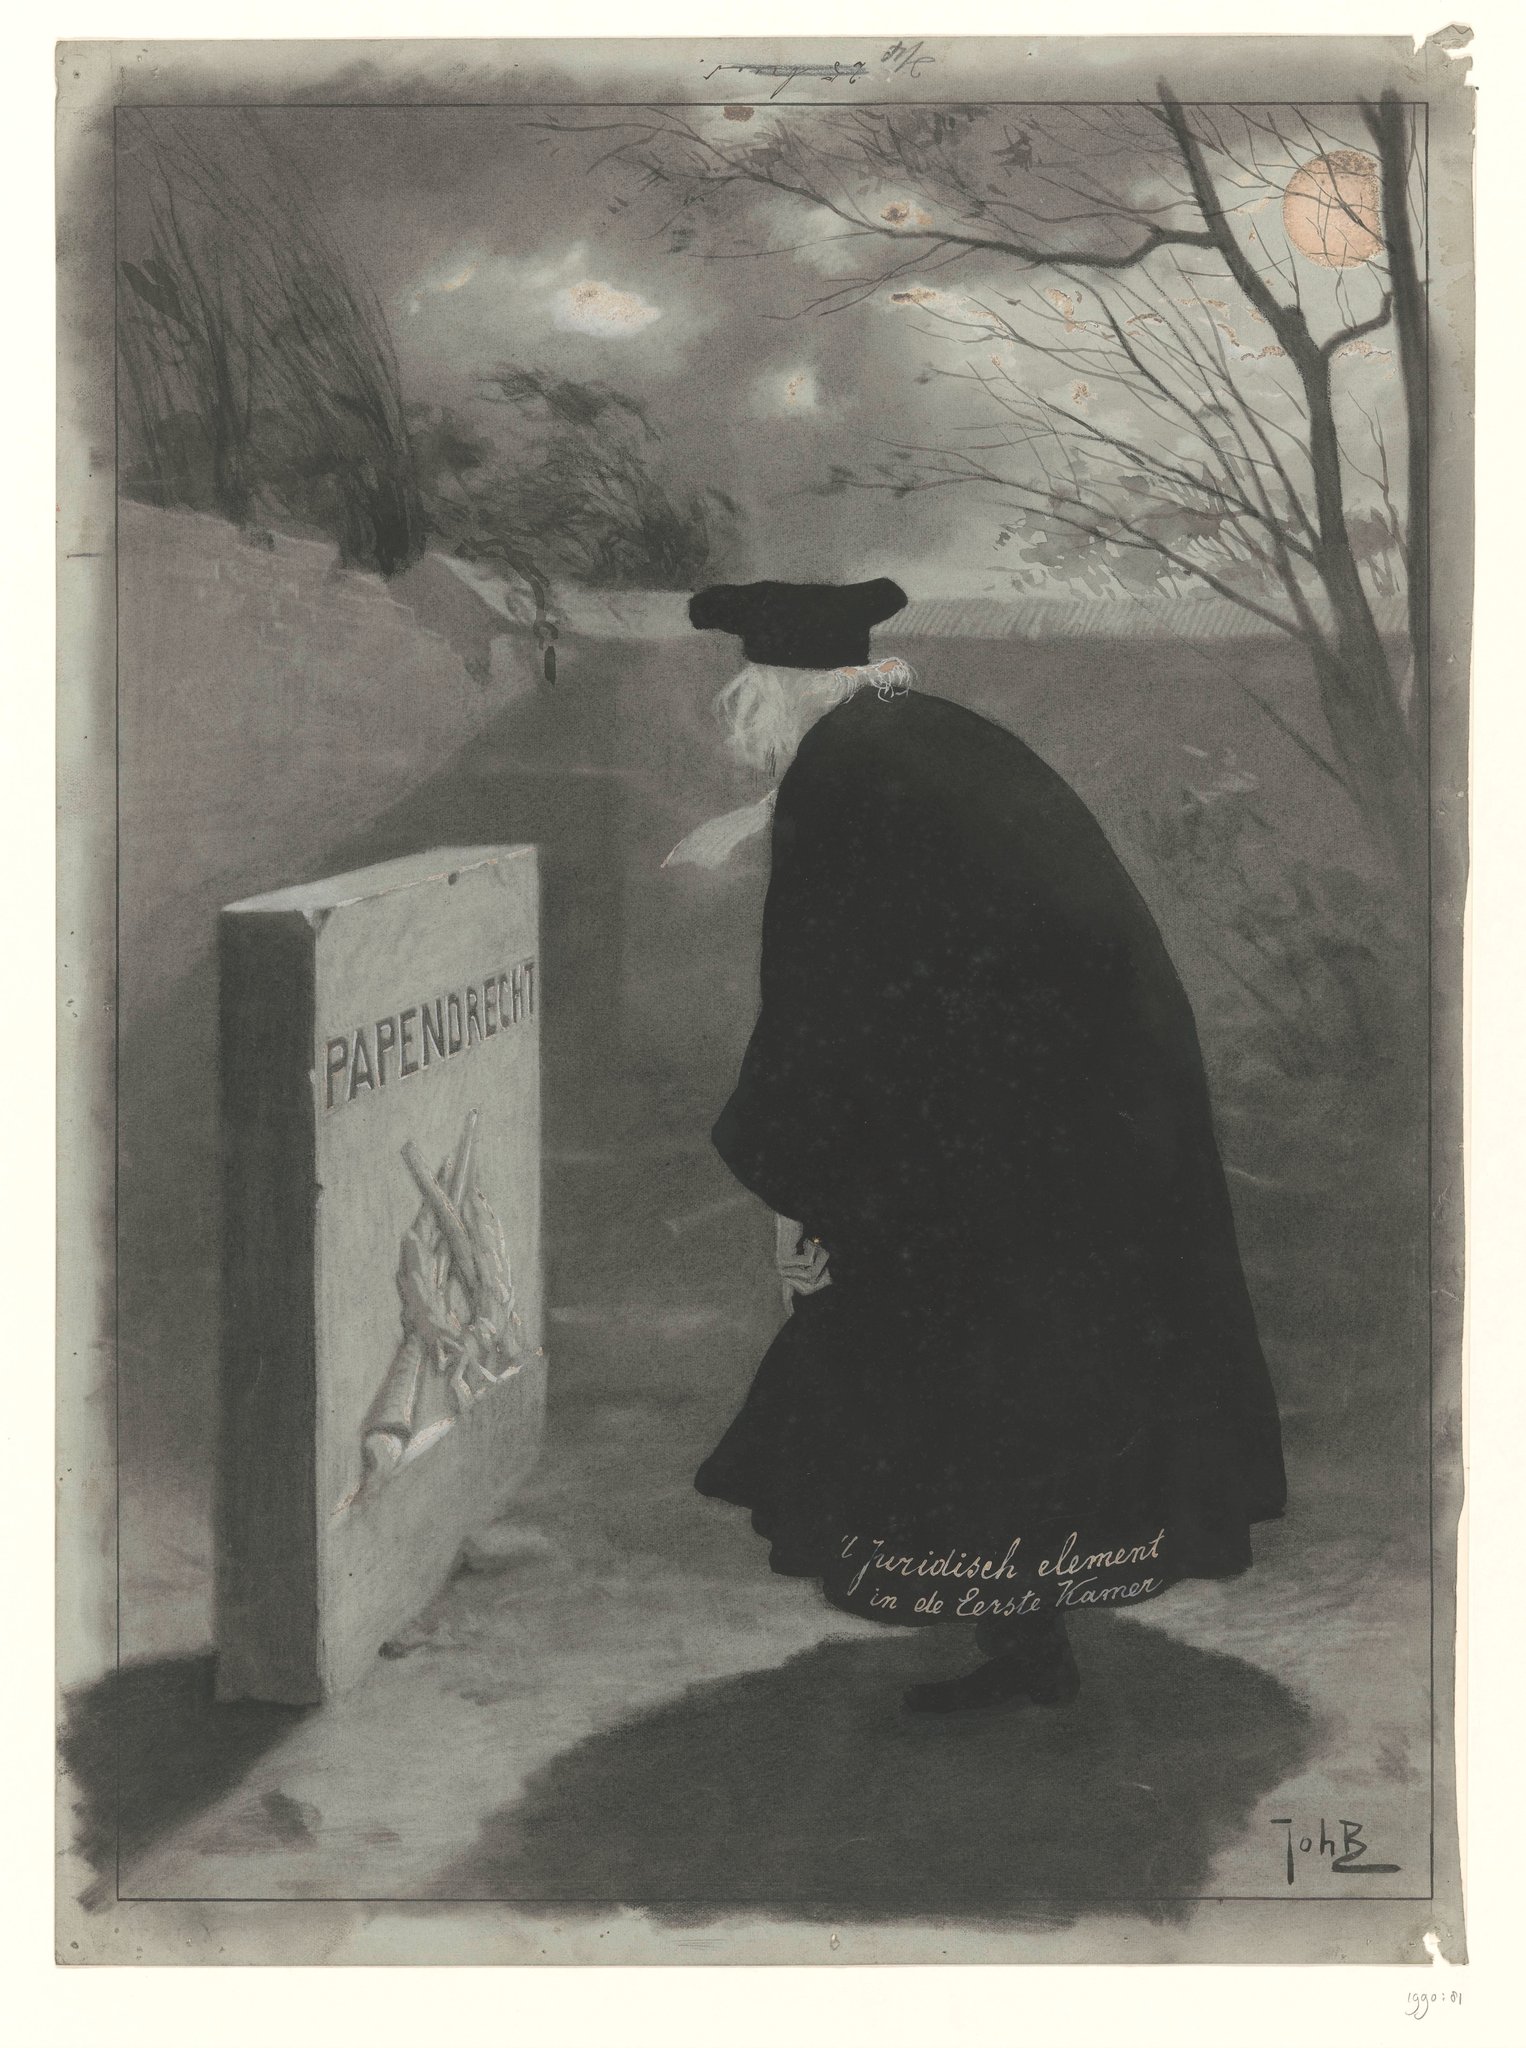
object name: drawing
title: Ontwerp voor illustratie in De Amsterdammer: 't Juridisch element in de Eerste Kamer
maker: johan braakensiek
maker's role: draughtsman, print maker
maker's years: 1858-1940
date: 1911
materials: chalk, paint, paper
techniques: brush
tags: political caricatures and satires